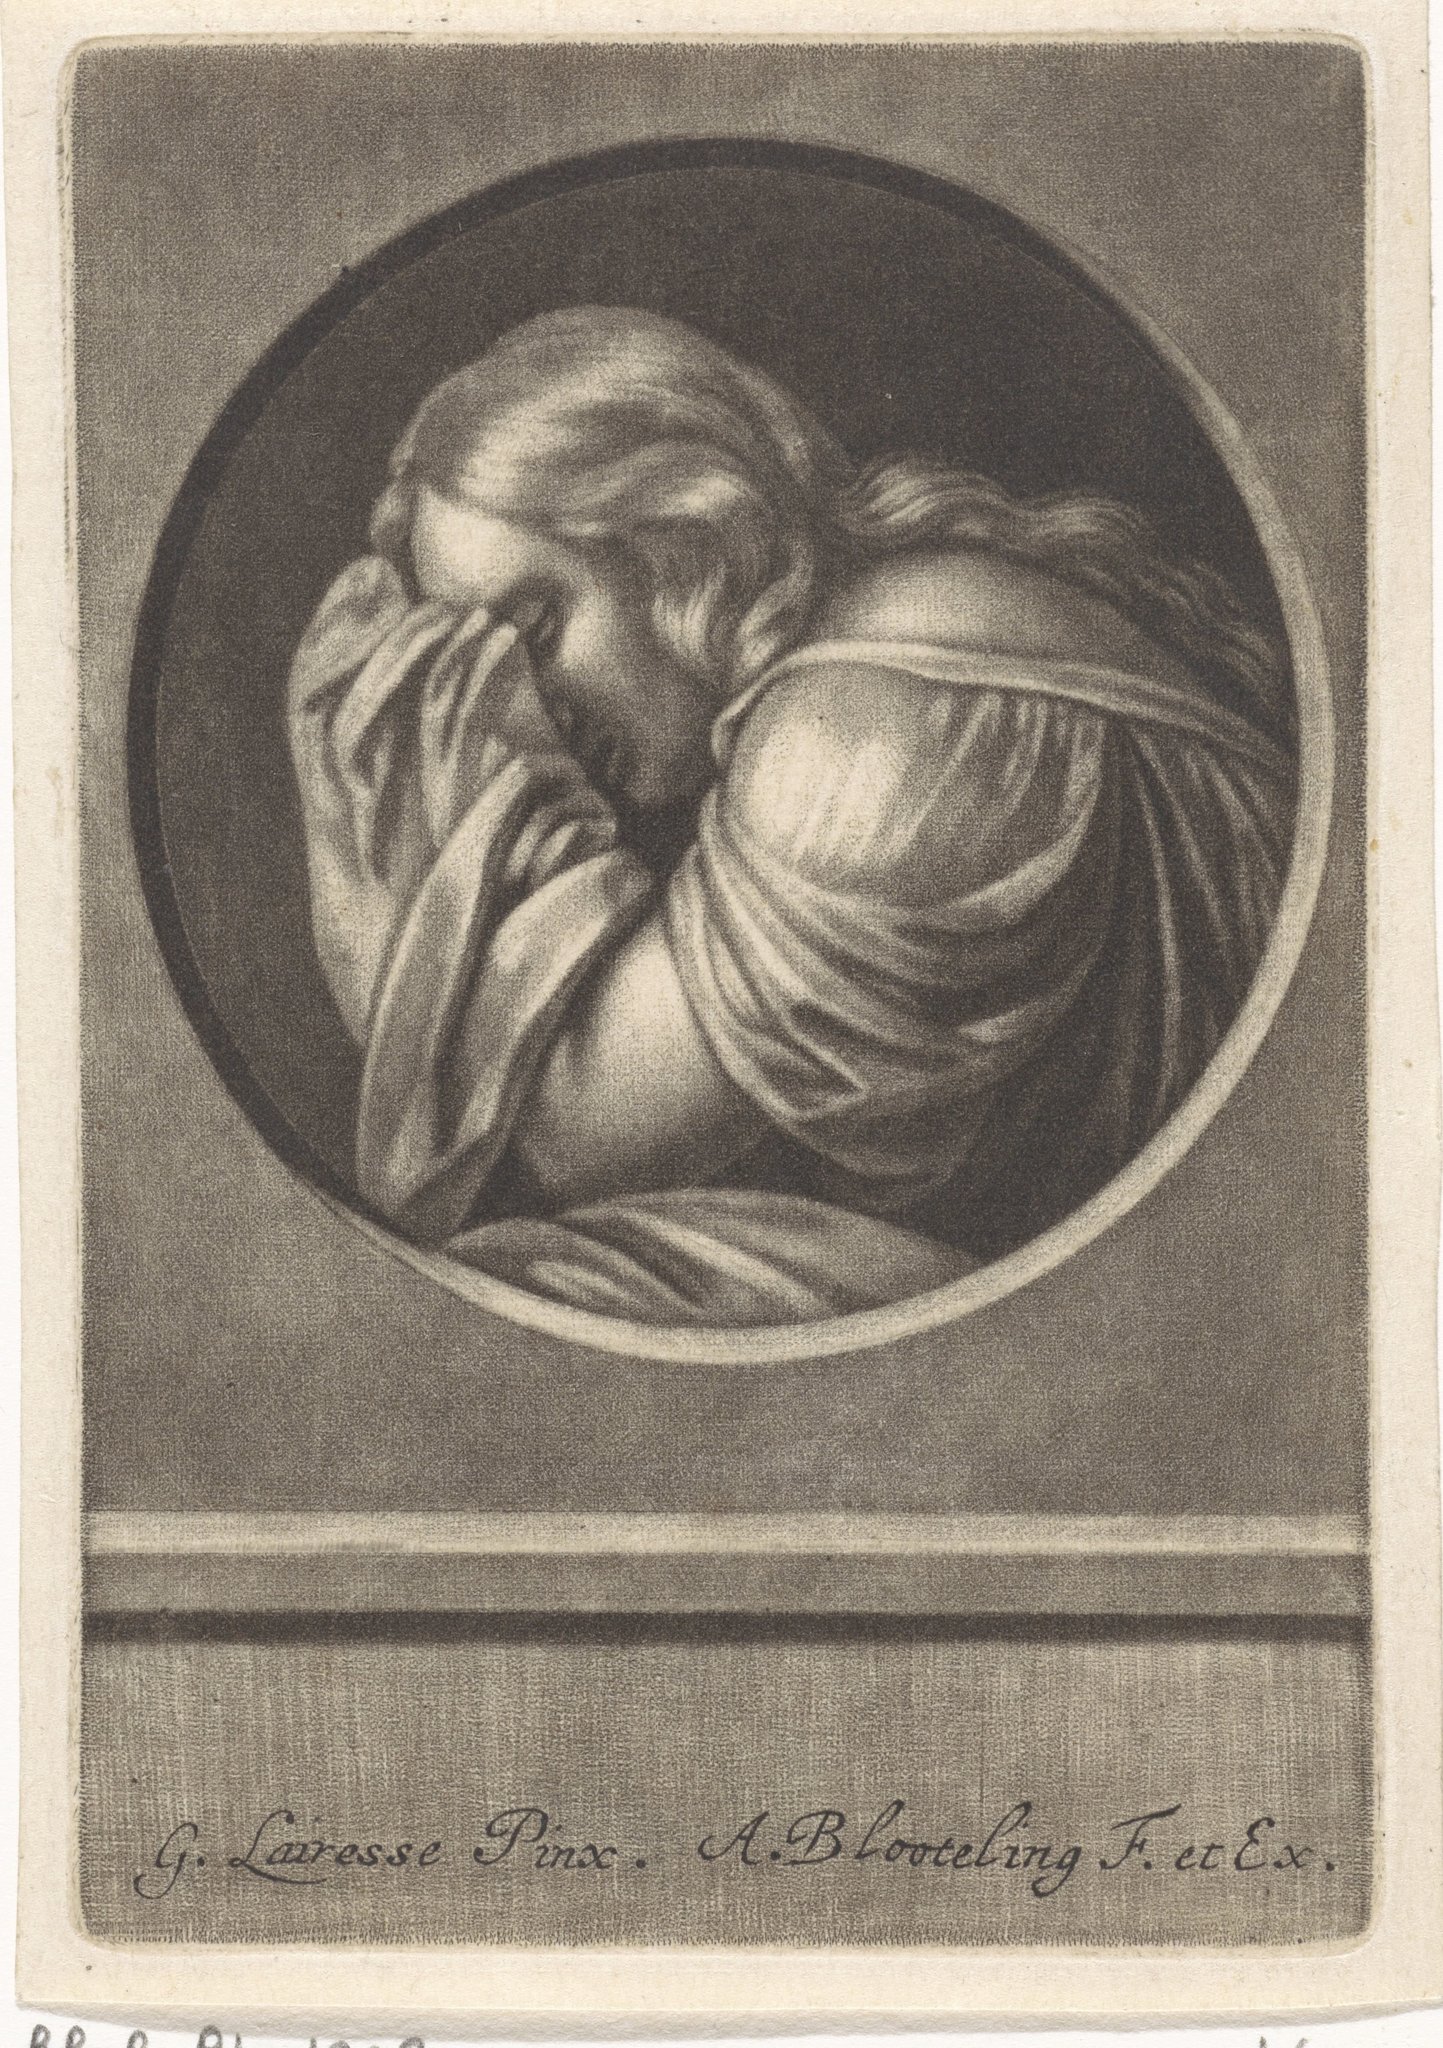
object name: print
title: Huilende jonge vrouw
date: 1652-1690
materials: paper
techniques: engraving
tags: weeping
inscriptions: collector's mark: Lugt 240